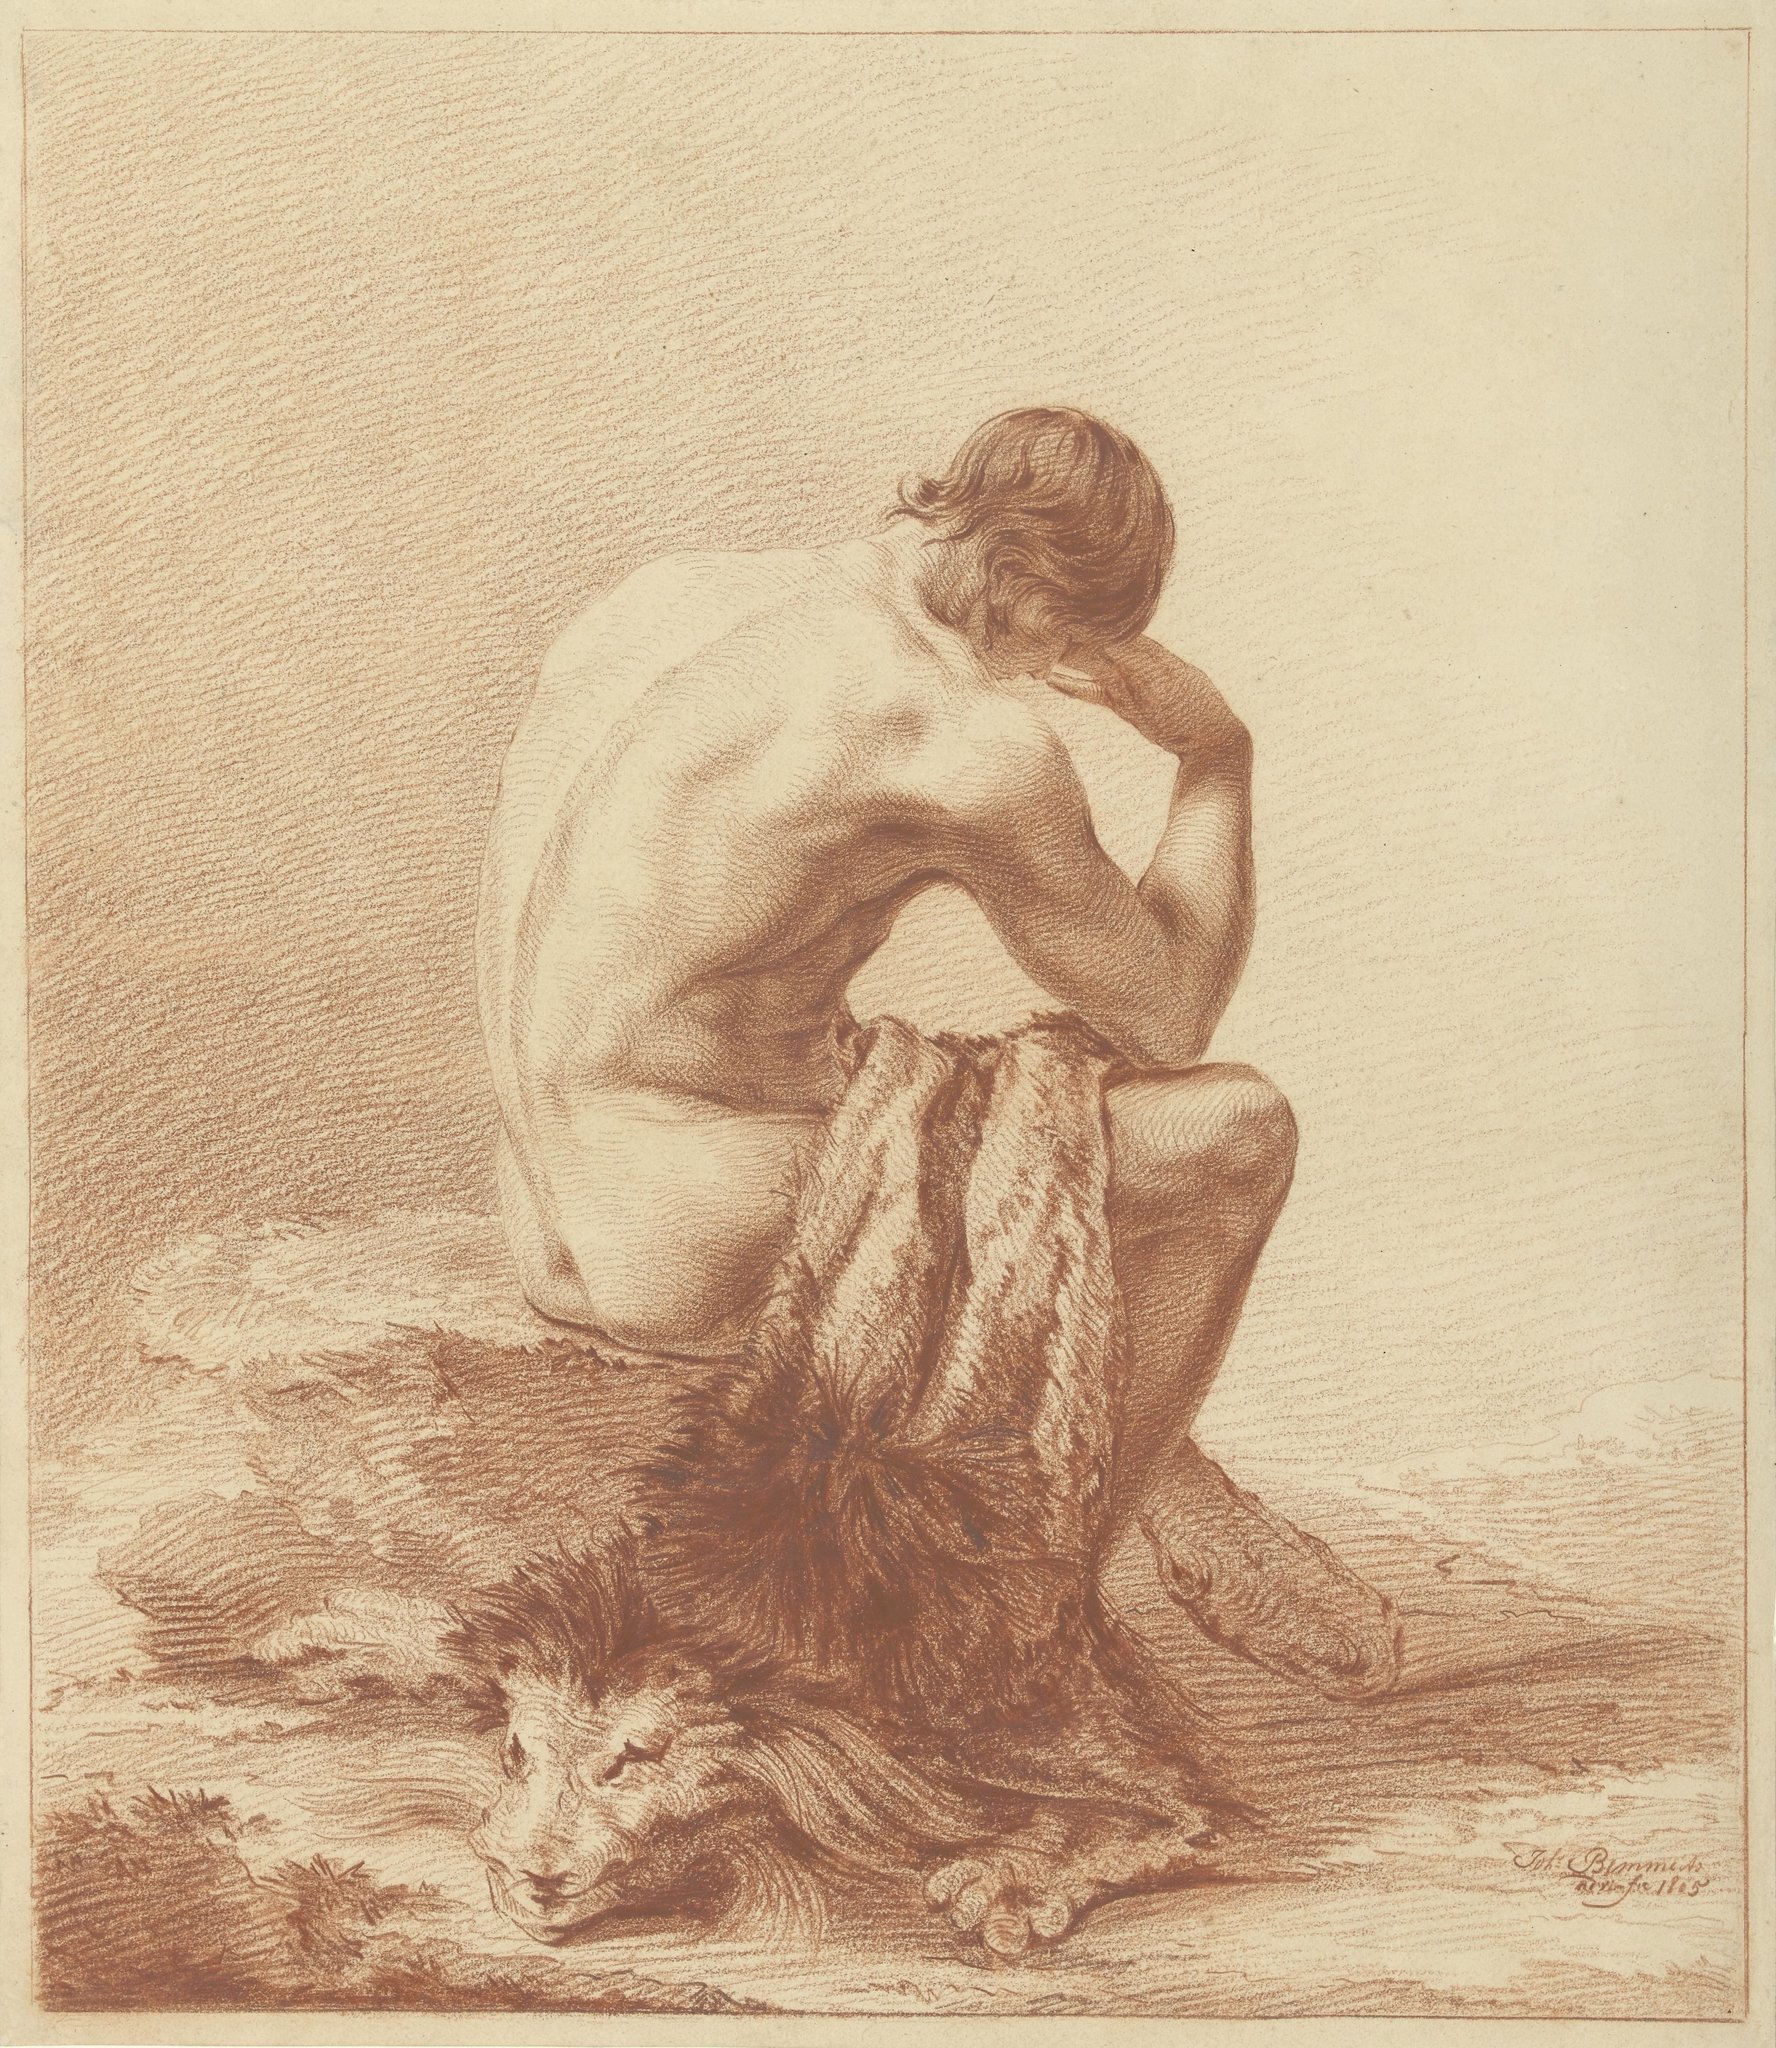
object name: drawing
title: De leeuwendoder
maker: joannes bemme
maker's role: print maker, printer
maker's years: 1775-1841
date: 1805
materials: chalk, paper